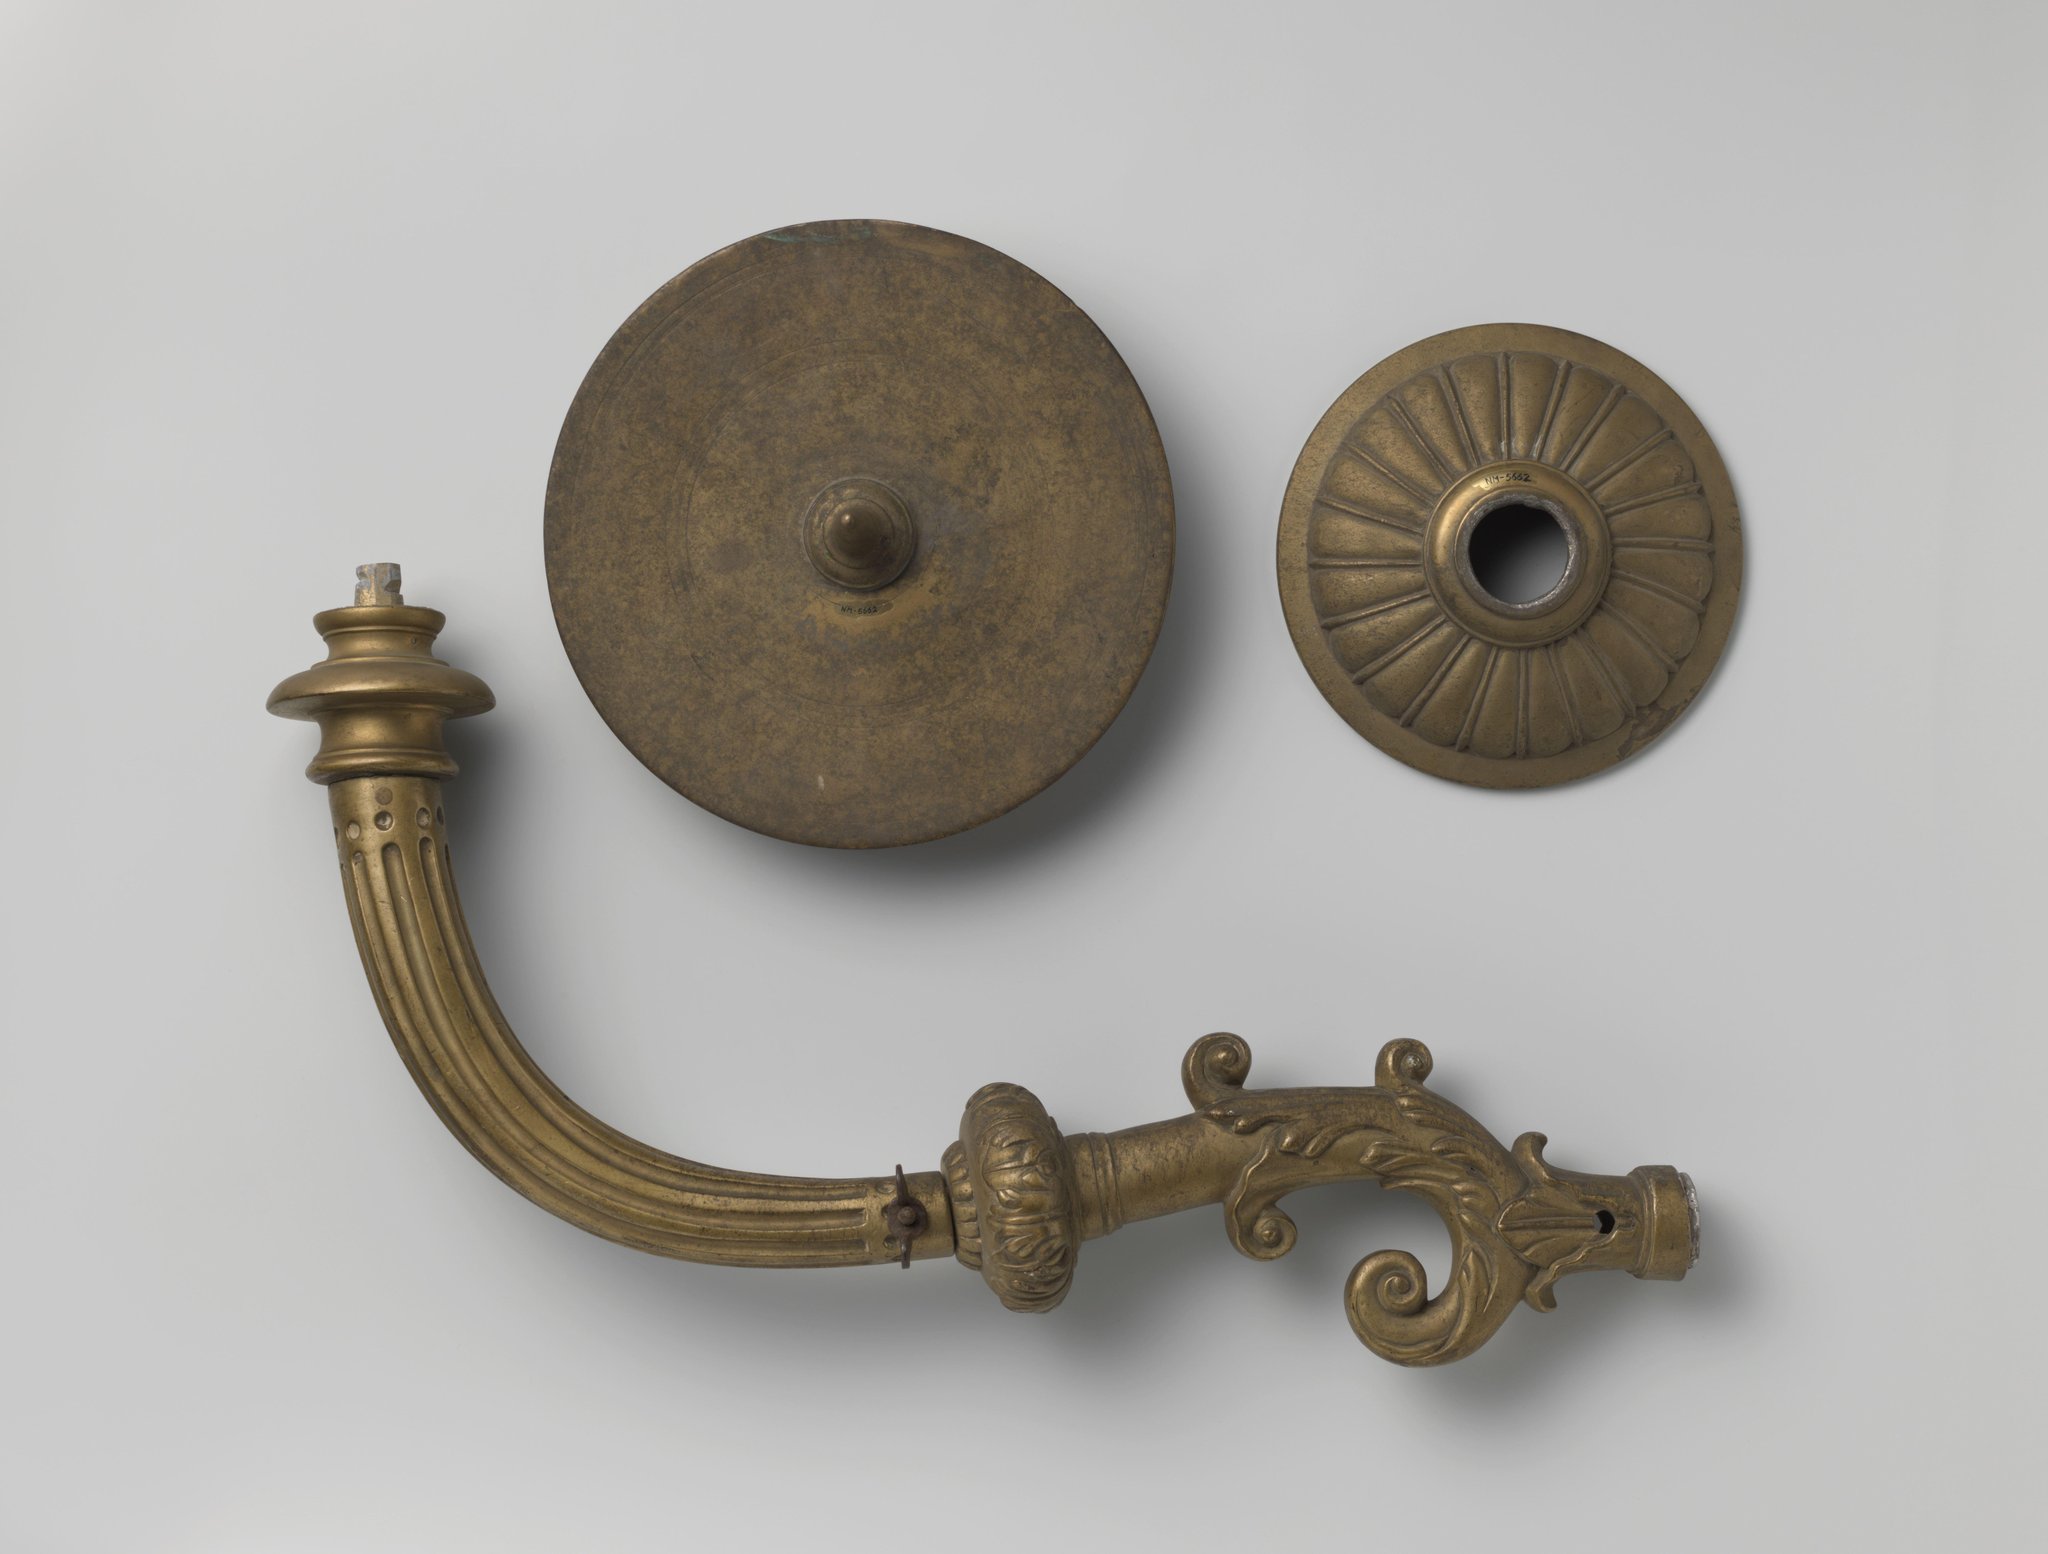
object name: lichtarm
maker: Anonymous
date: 1590-1610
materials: brass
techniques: casting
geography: mechelen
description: Het voorwerp bestaat uit de volgende vijf onderdelen: het gedeelte ter bevestiging aan de wand, twee stukken, welke de arm vormen, het gedeelte onder de vetvanger, dat met een koperen pin aan de arm is geklonken, de vetvanger met de kaarsenpin. Het ronde wandgedeelte is met knorren versierd. Het eerste gedeelte van de arm bestaat uit een met bladmotieven versierde aanzet waarop het stuk aansluit, dat enerzijds bestaat uit een met acanthusbladeren versierde krul, anderzijds uit een met acanthusbladeren versierde nodus. Dan komt het zich omhoog buigende, met cannelures versierde gedeelte met een uitkraging tussen holronde profileringen op het eind. Daarop is de vetvanger met de pin geplaatst. Deze is aan de onderkant voorzien van knorren en heeft een aanzet in de vorm van een vaas.